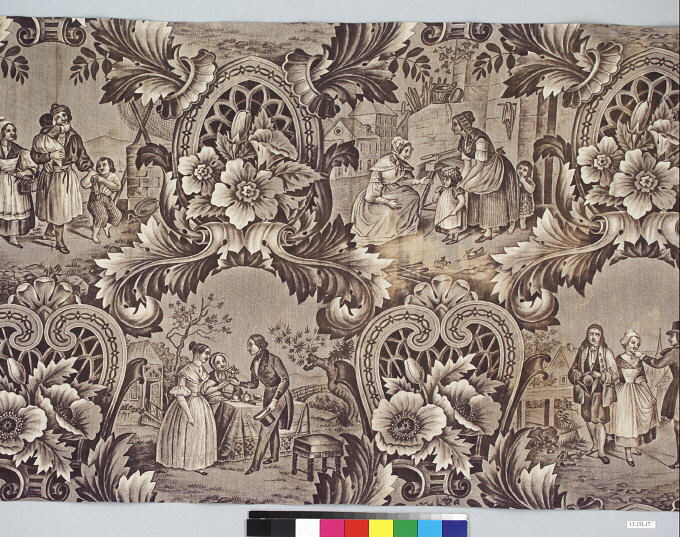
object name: furnishing textile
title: Pictorial print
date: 1830-1835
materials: cotton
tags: boys,men,women,flowers,leaves